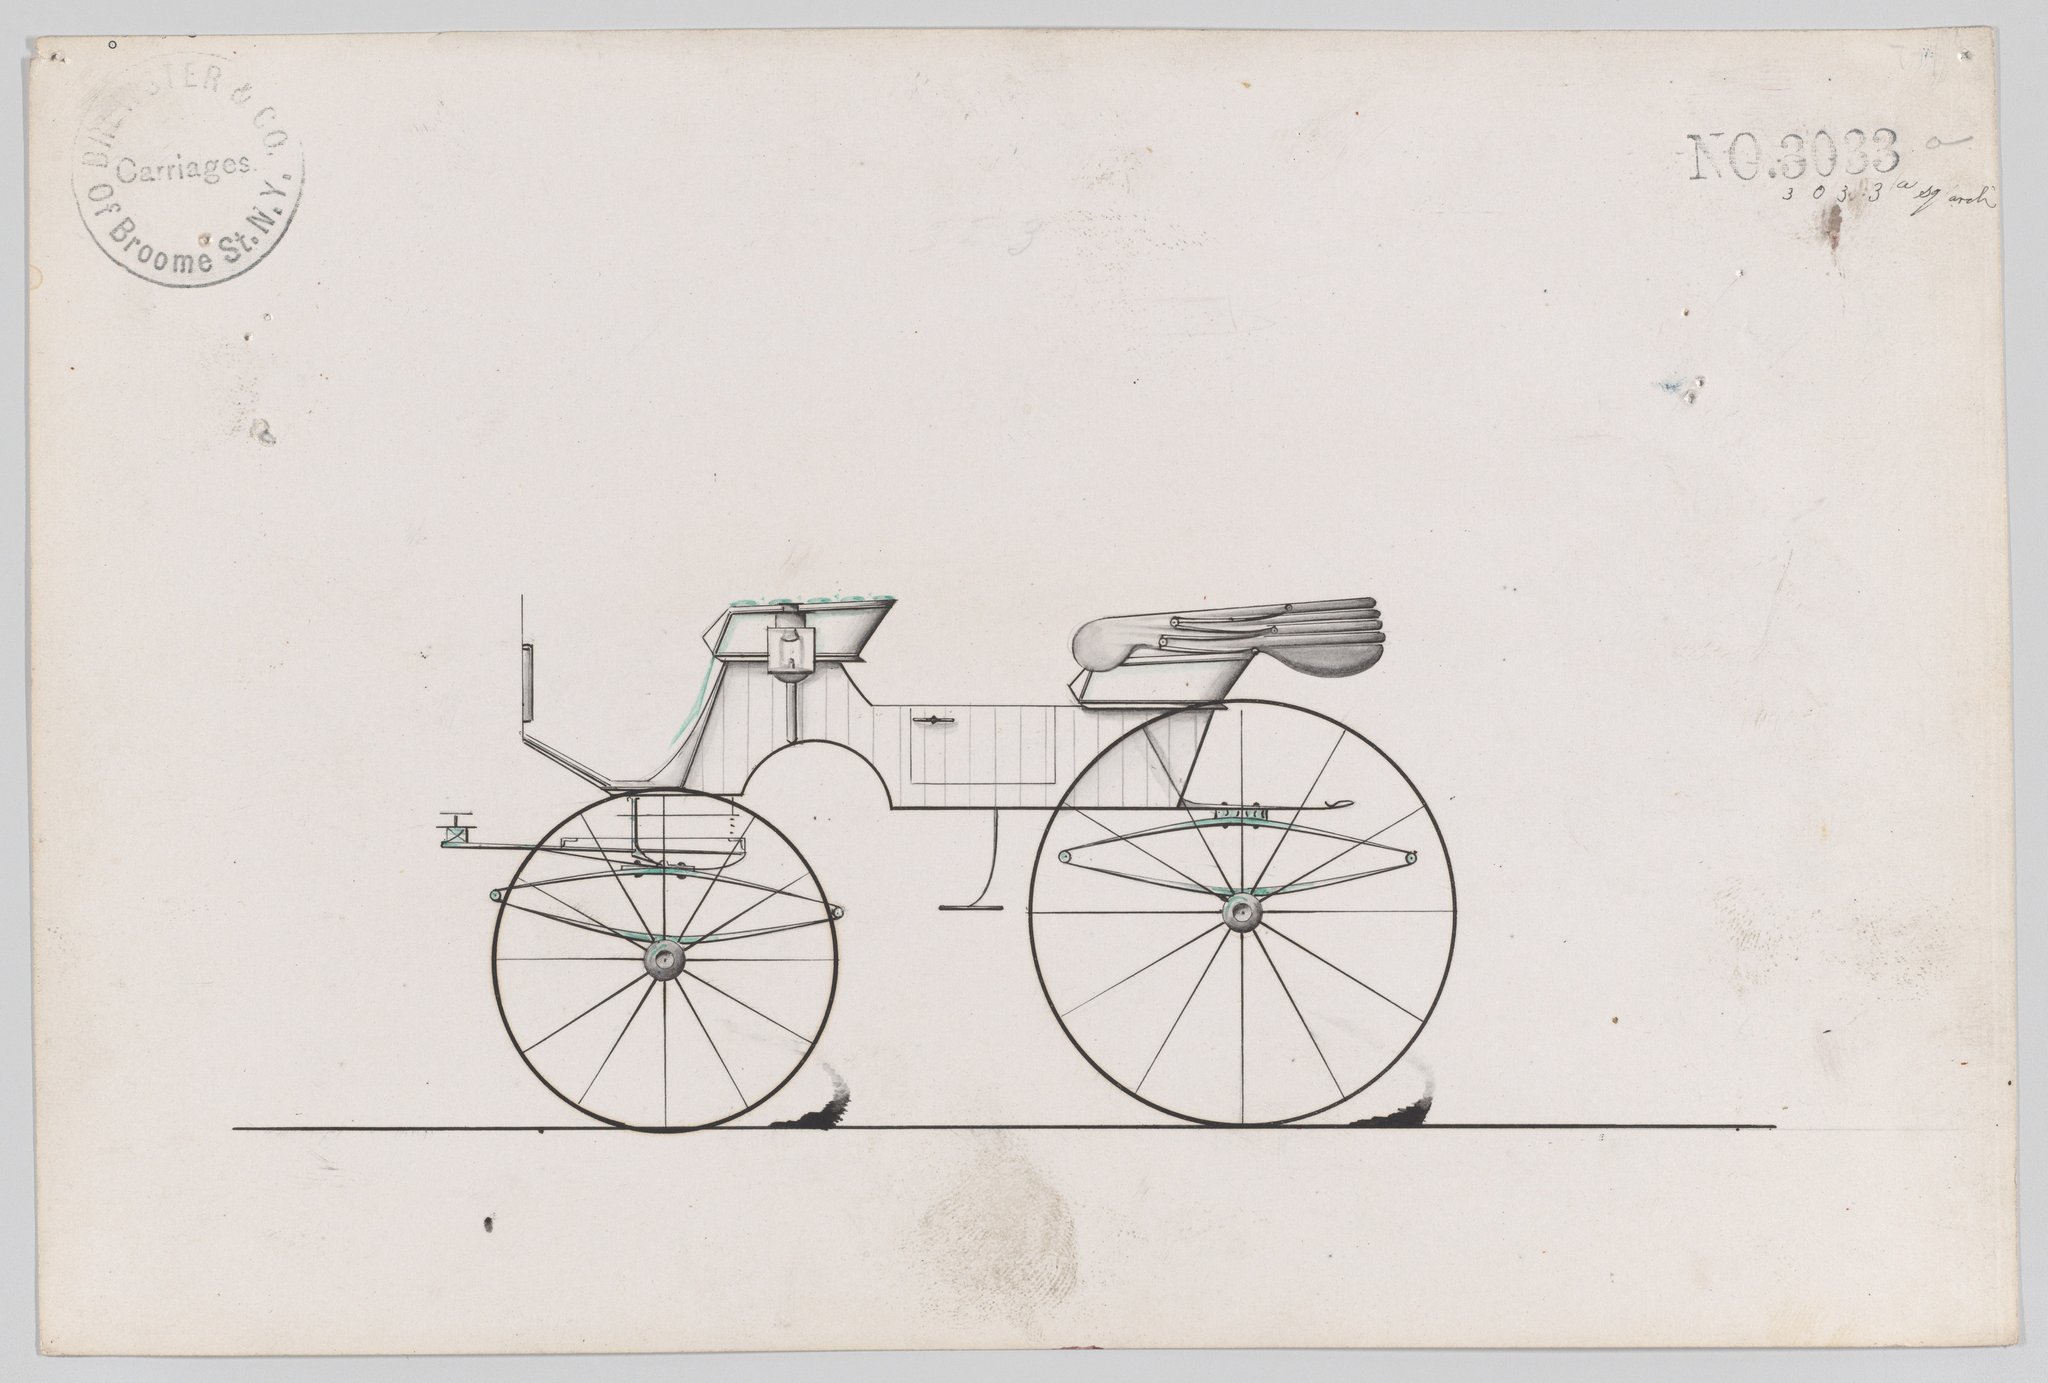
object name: drawing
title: Design for 2 seat Phaeton, no. 3033a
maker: brewster & co.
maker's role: manufacturer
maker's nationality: american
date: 1874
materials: gouache, graphite, ink, watercolor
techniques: pen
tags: carriages